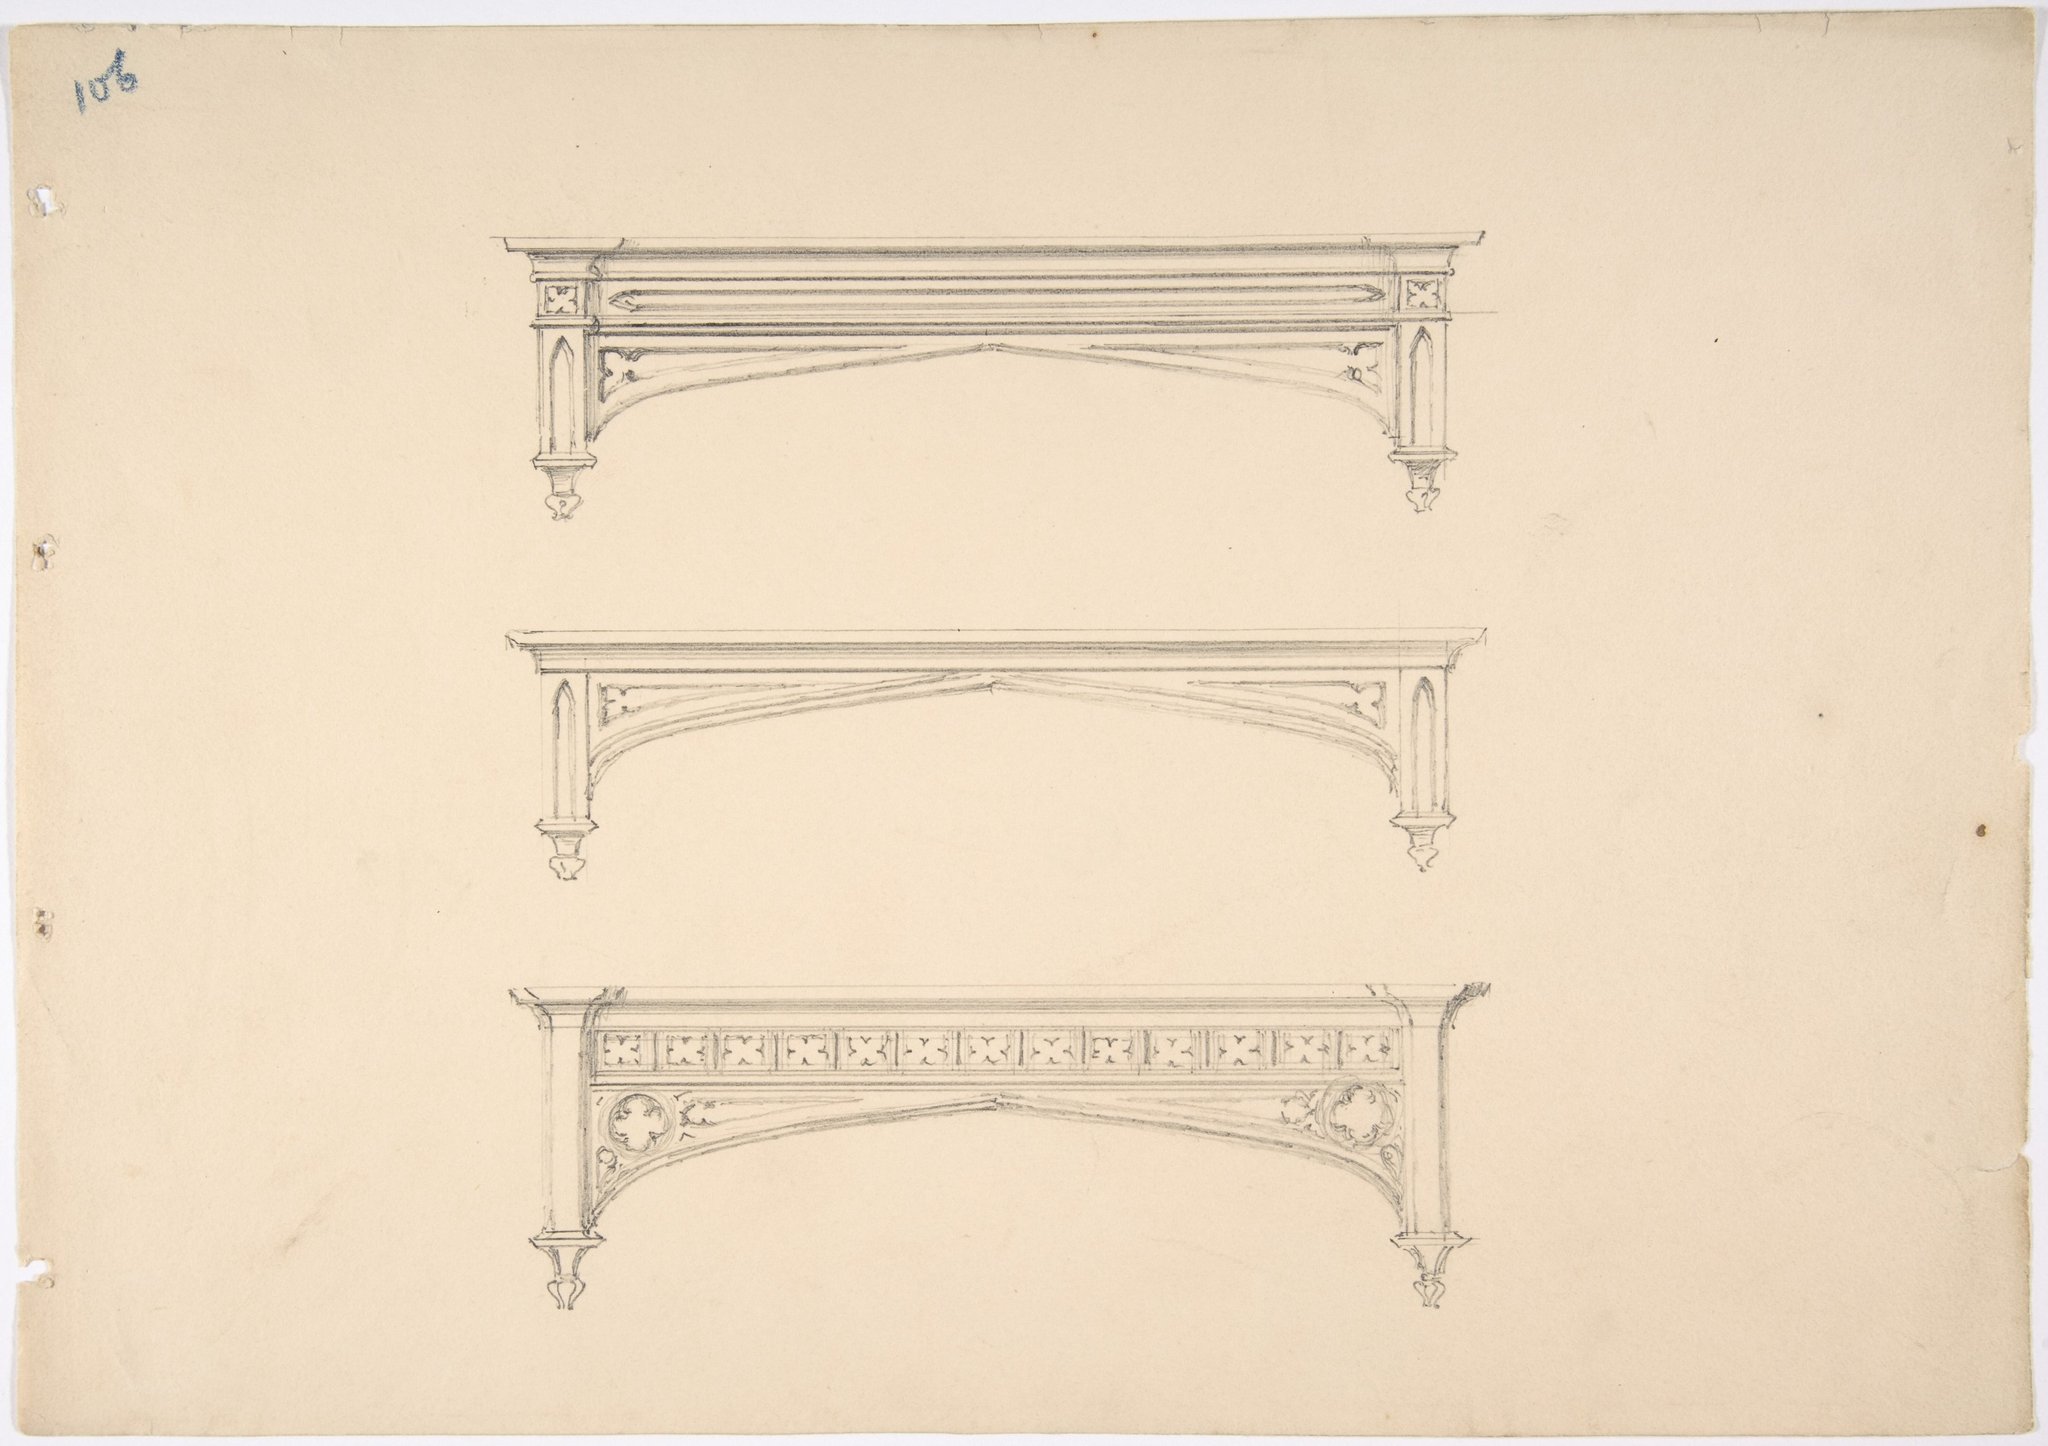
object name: drawing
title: Design for Three Gothic Pediments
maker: anonymous, british, 19th century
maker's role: artist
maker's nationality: british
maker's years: 1800-1900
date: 1801-1833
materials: graphite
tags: architecture